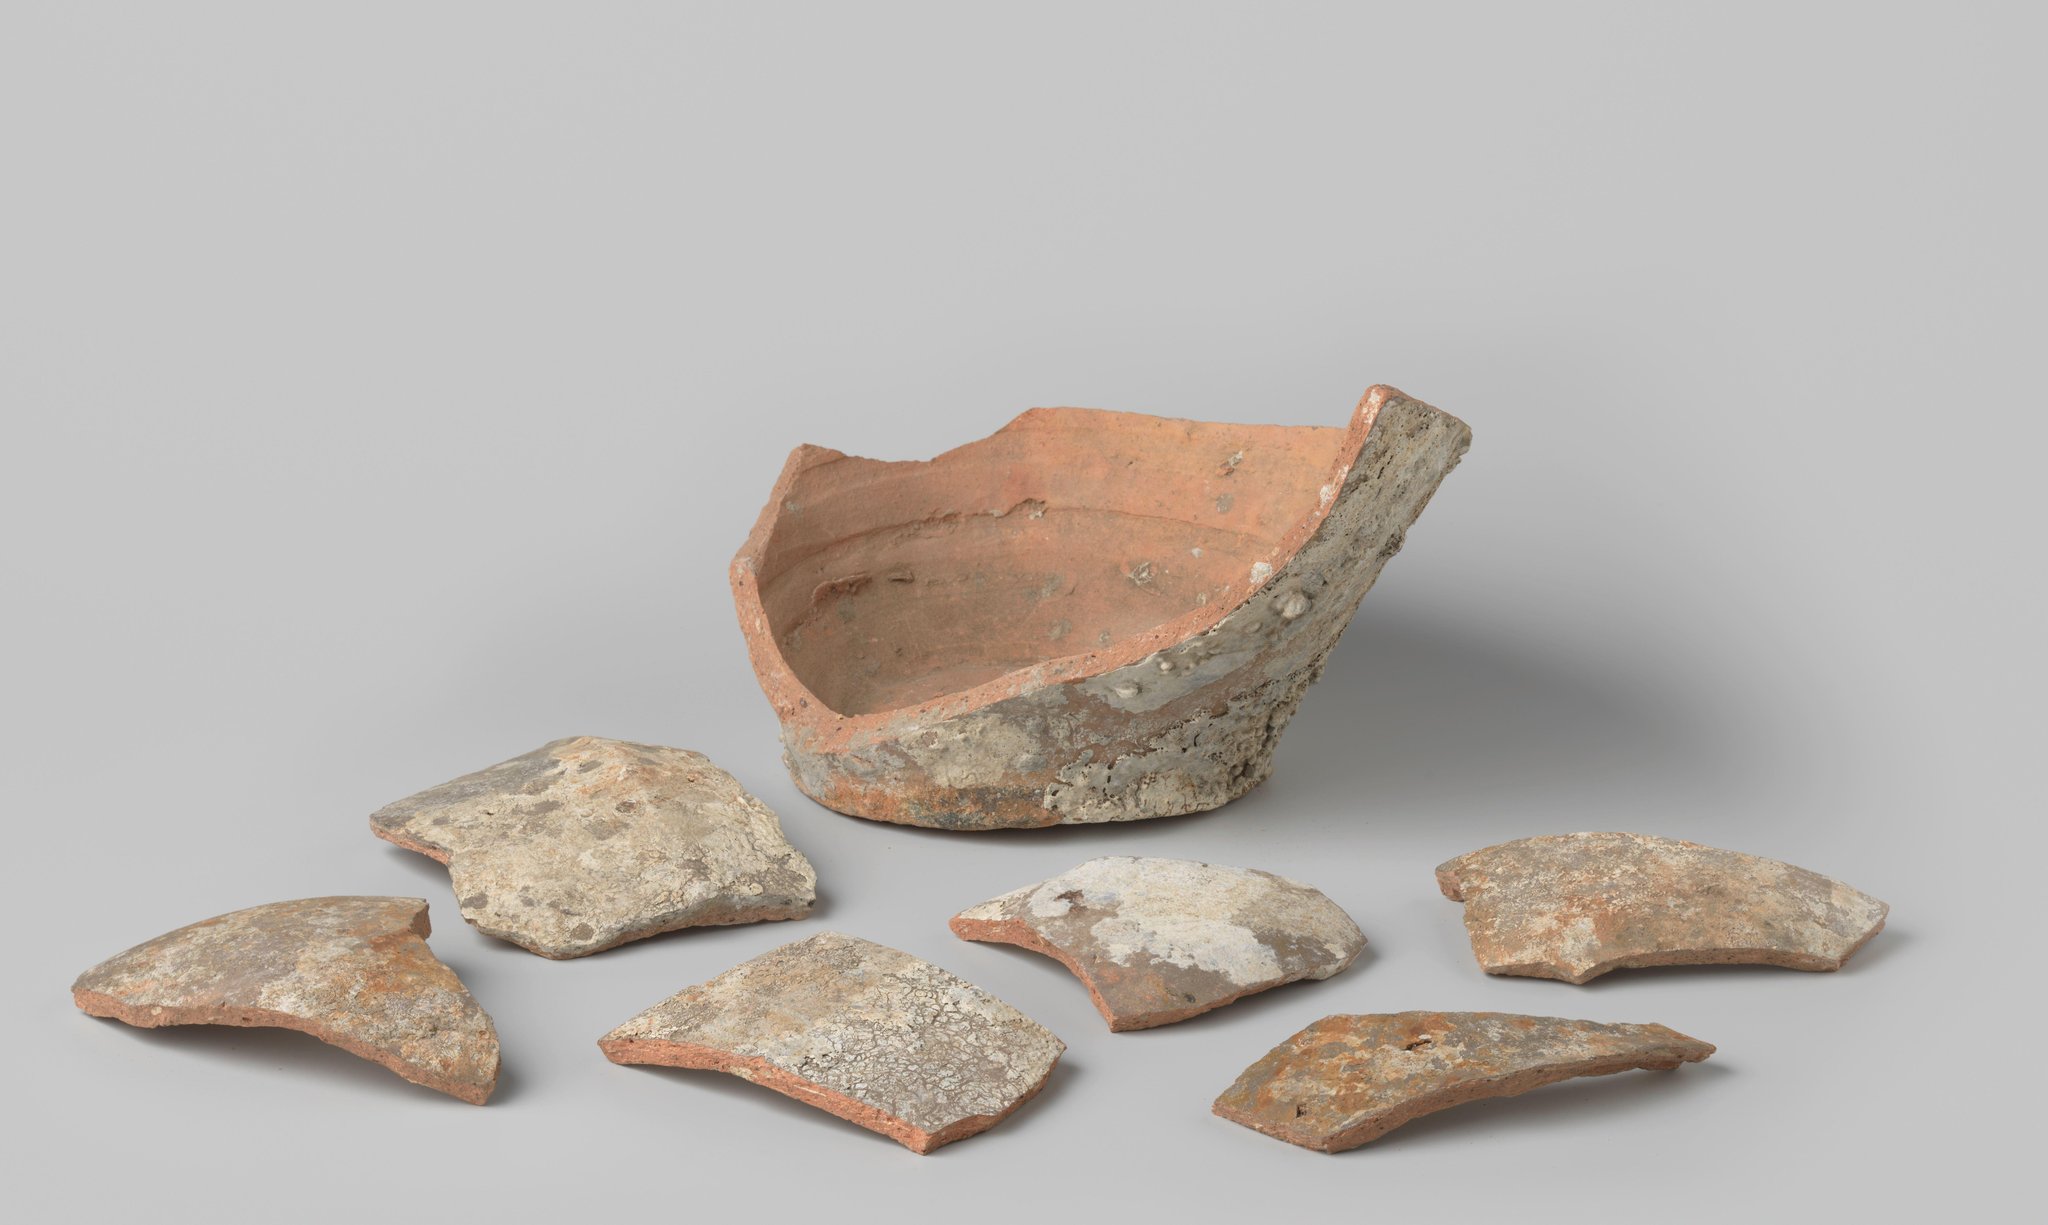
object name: martavaan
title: Scherven van een martavaan uit V.O.C.-schip de 'Witte Leeuw'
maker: Anonymous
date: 1613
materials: earthenware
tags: verenigde oostindische compagnie, sint-helena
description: Scherven van een martavaan uit V.O.C.-schip de 'Witte Leeuw'.